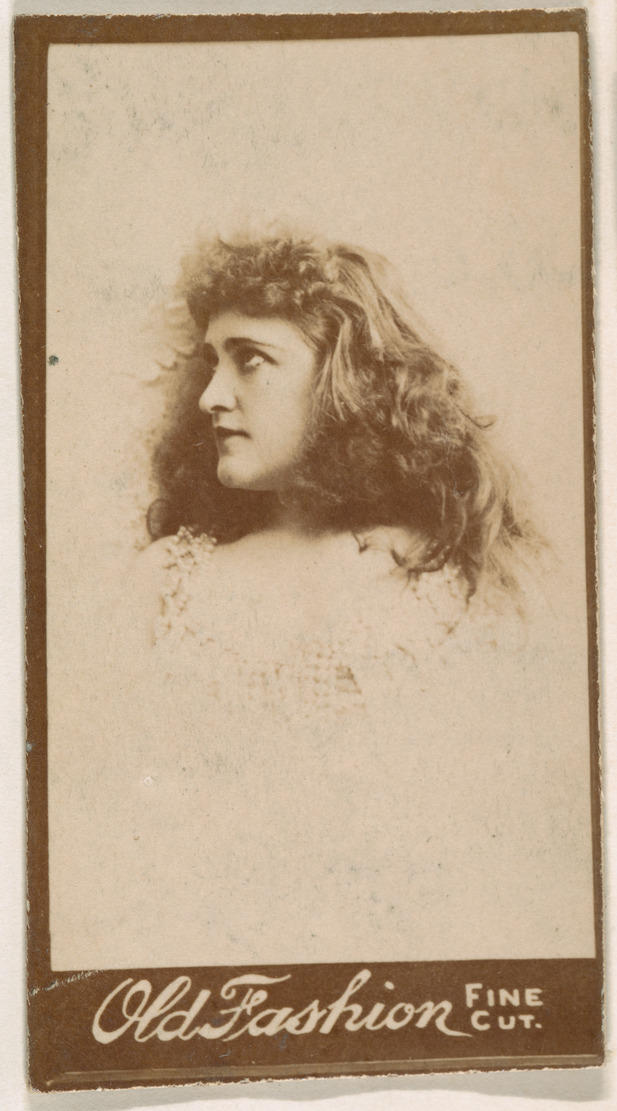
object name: photograph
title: Portrait of actress in profile, from the Actresses series (N664) promoting Old Fashion Fine Cut Tobacco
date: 1888-1890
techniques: albumen silver print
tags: portraits,women,actresses